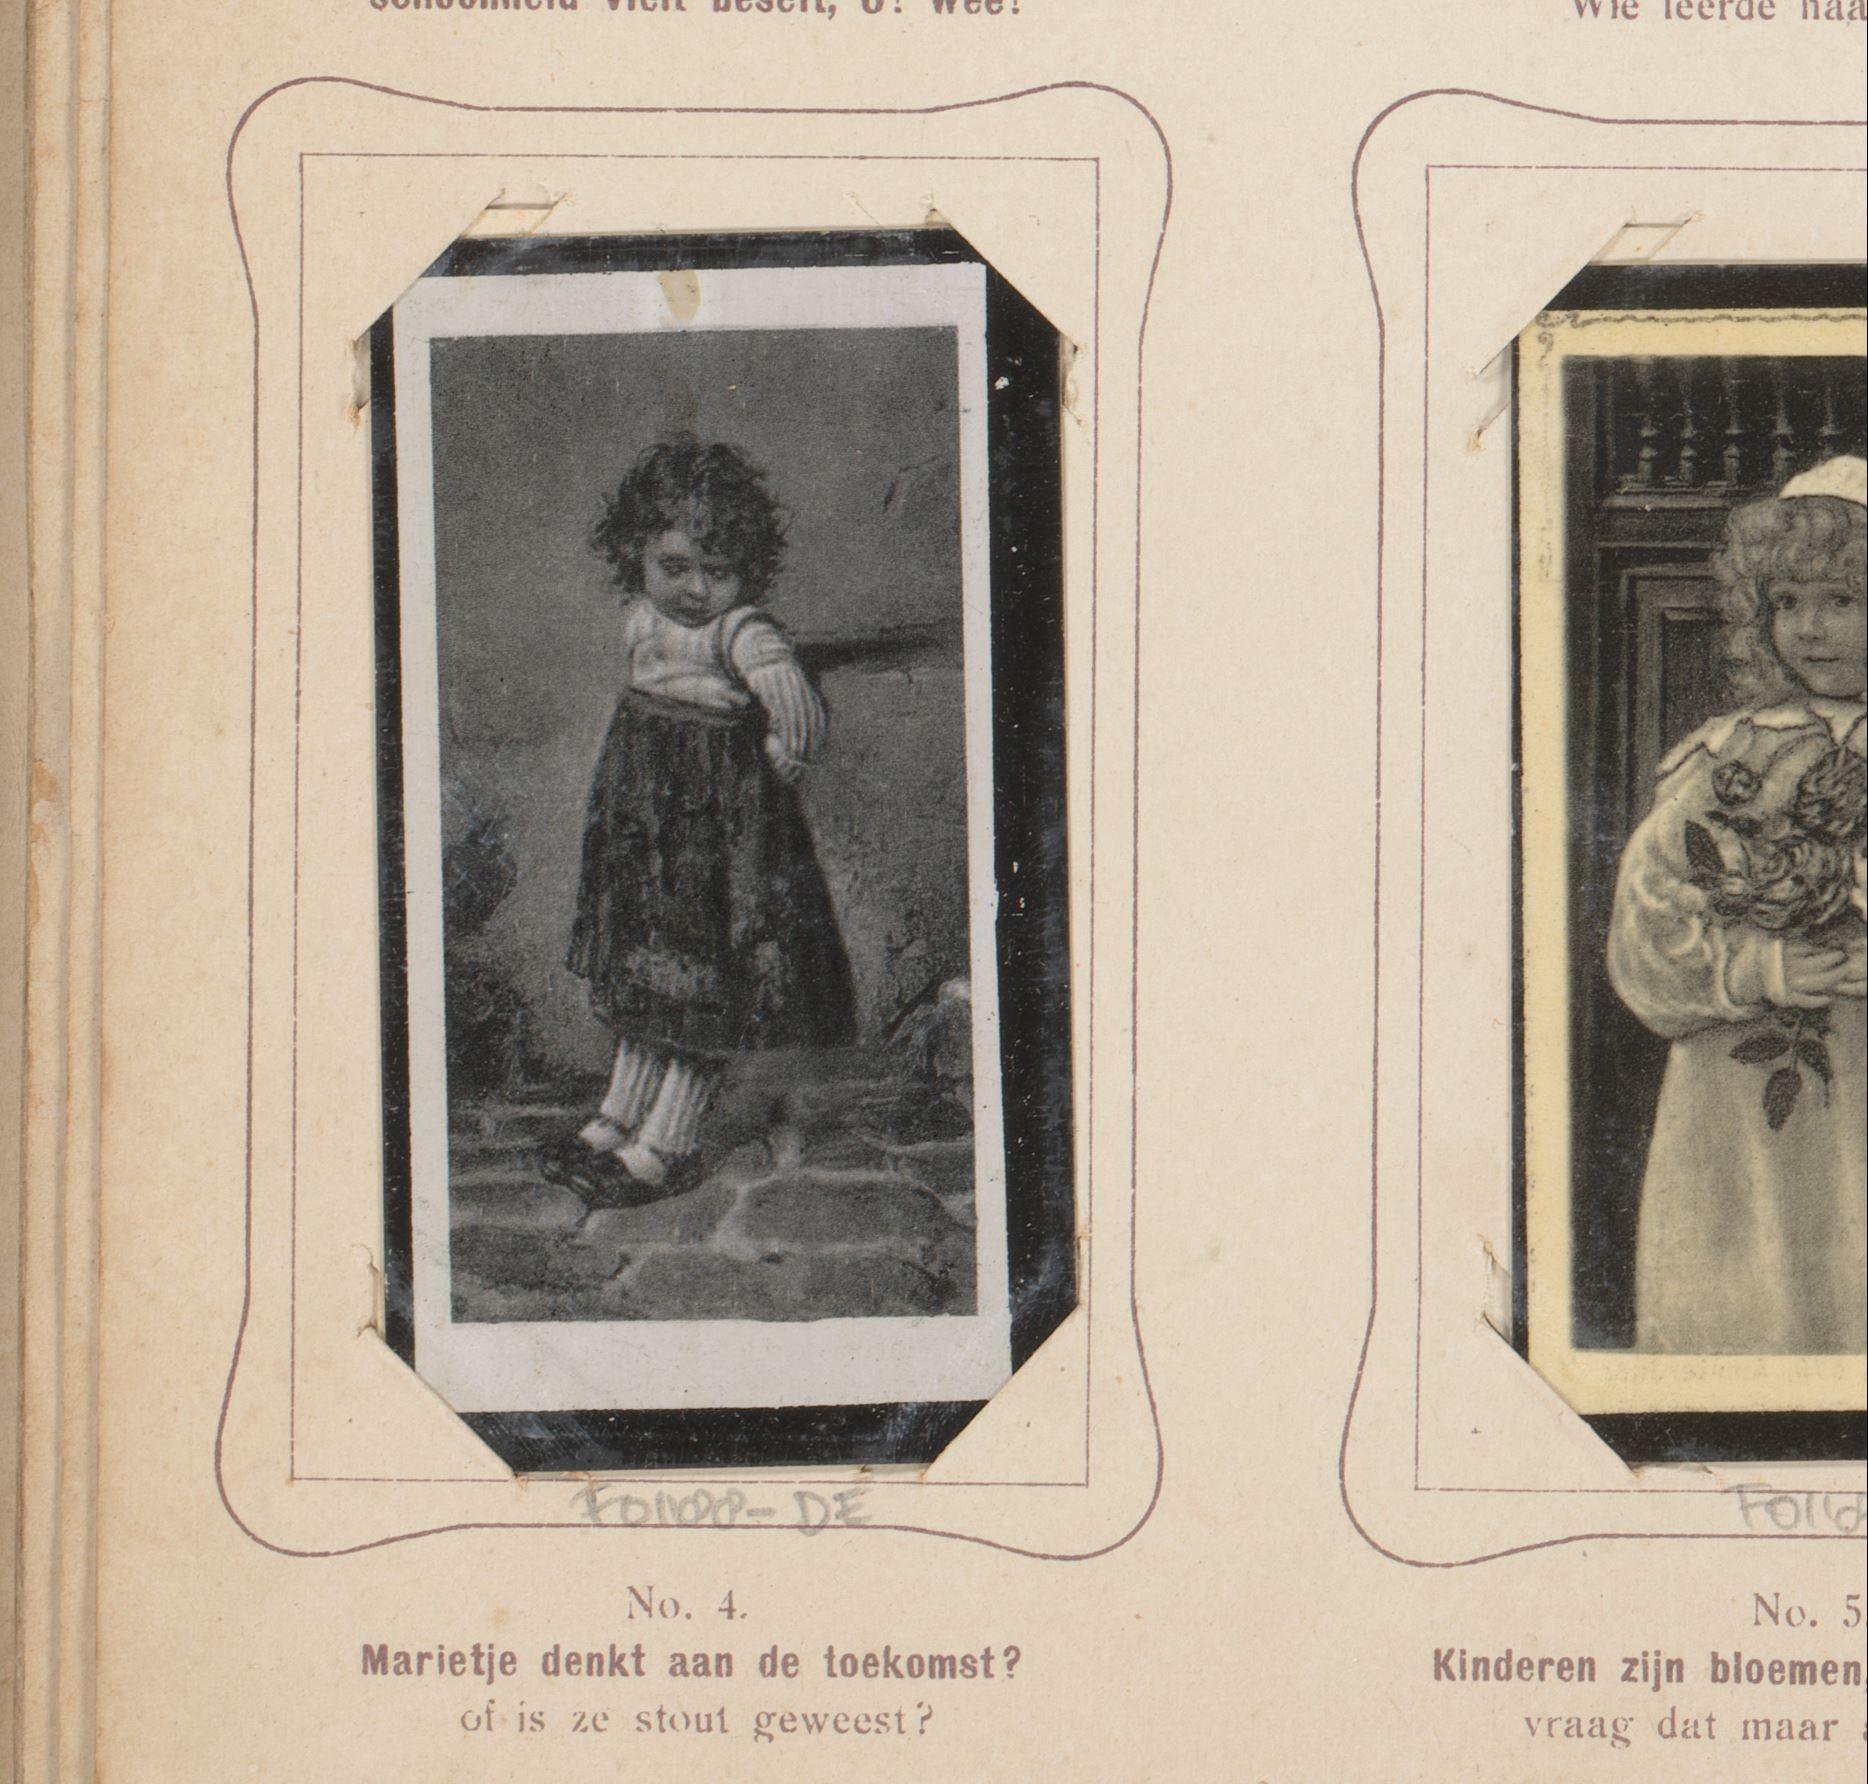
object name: album leaf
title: Reproductie van een tekening van een meisje in gedachten verzonken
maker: Anonymous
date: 1906-1907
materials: paper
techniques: photograph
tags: thinking, thought, reflection; 'pensiero' (ripa), girl (child between toddler and youth)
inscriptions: inscription: ‘No. 4./ Marietje denkt aan de toekomst?/ of is ze stout geweest?’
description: Deze prent maakt deel uit van een album.